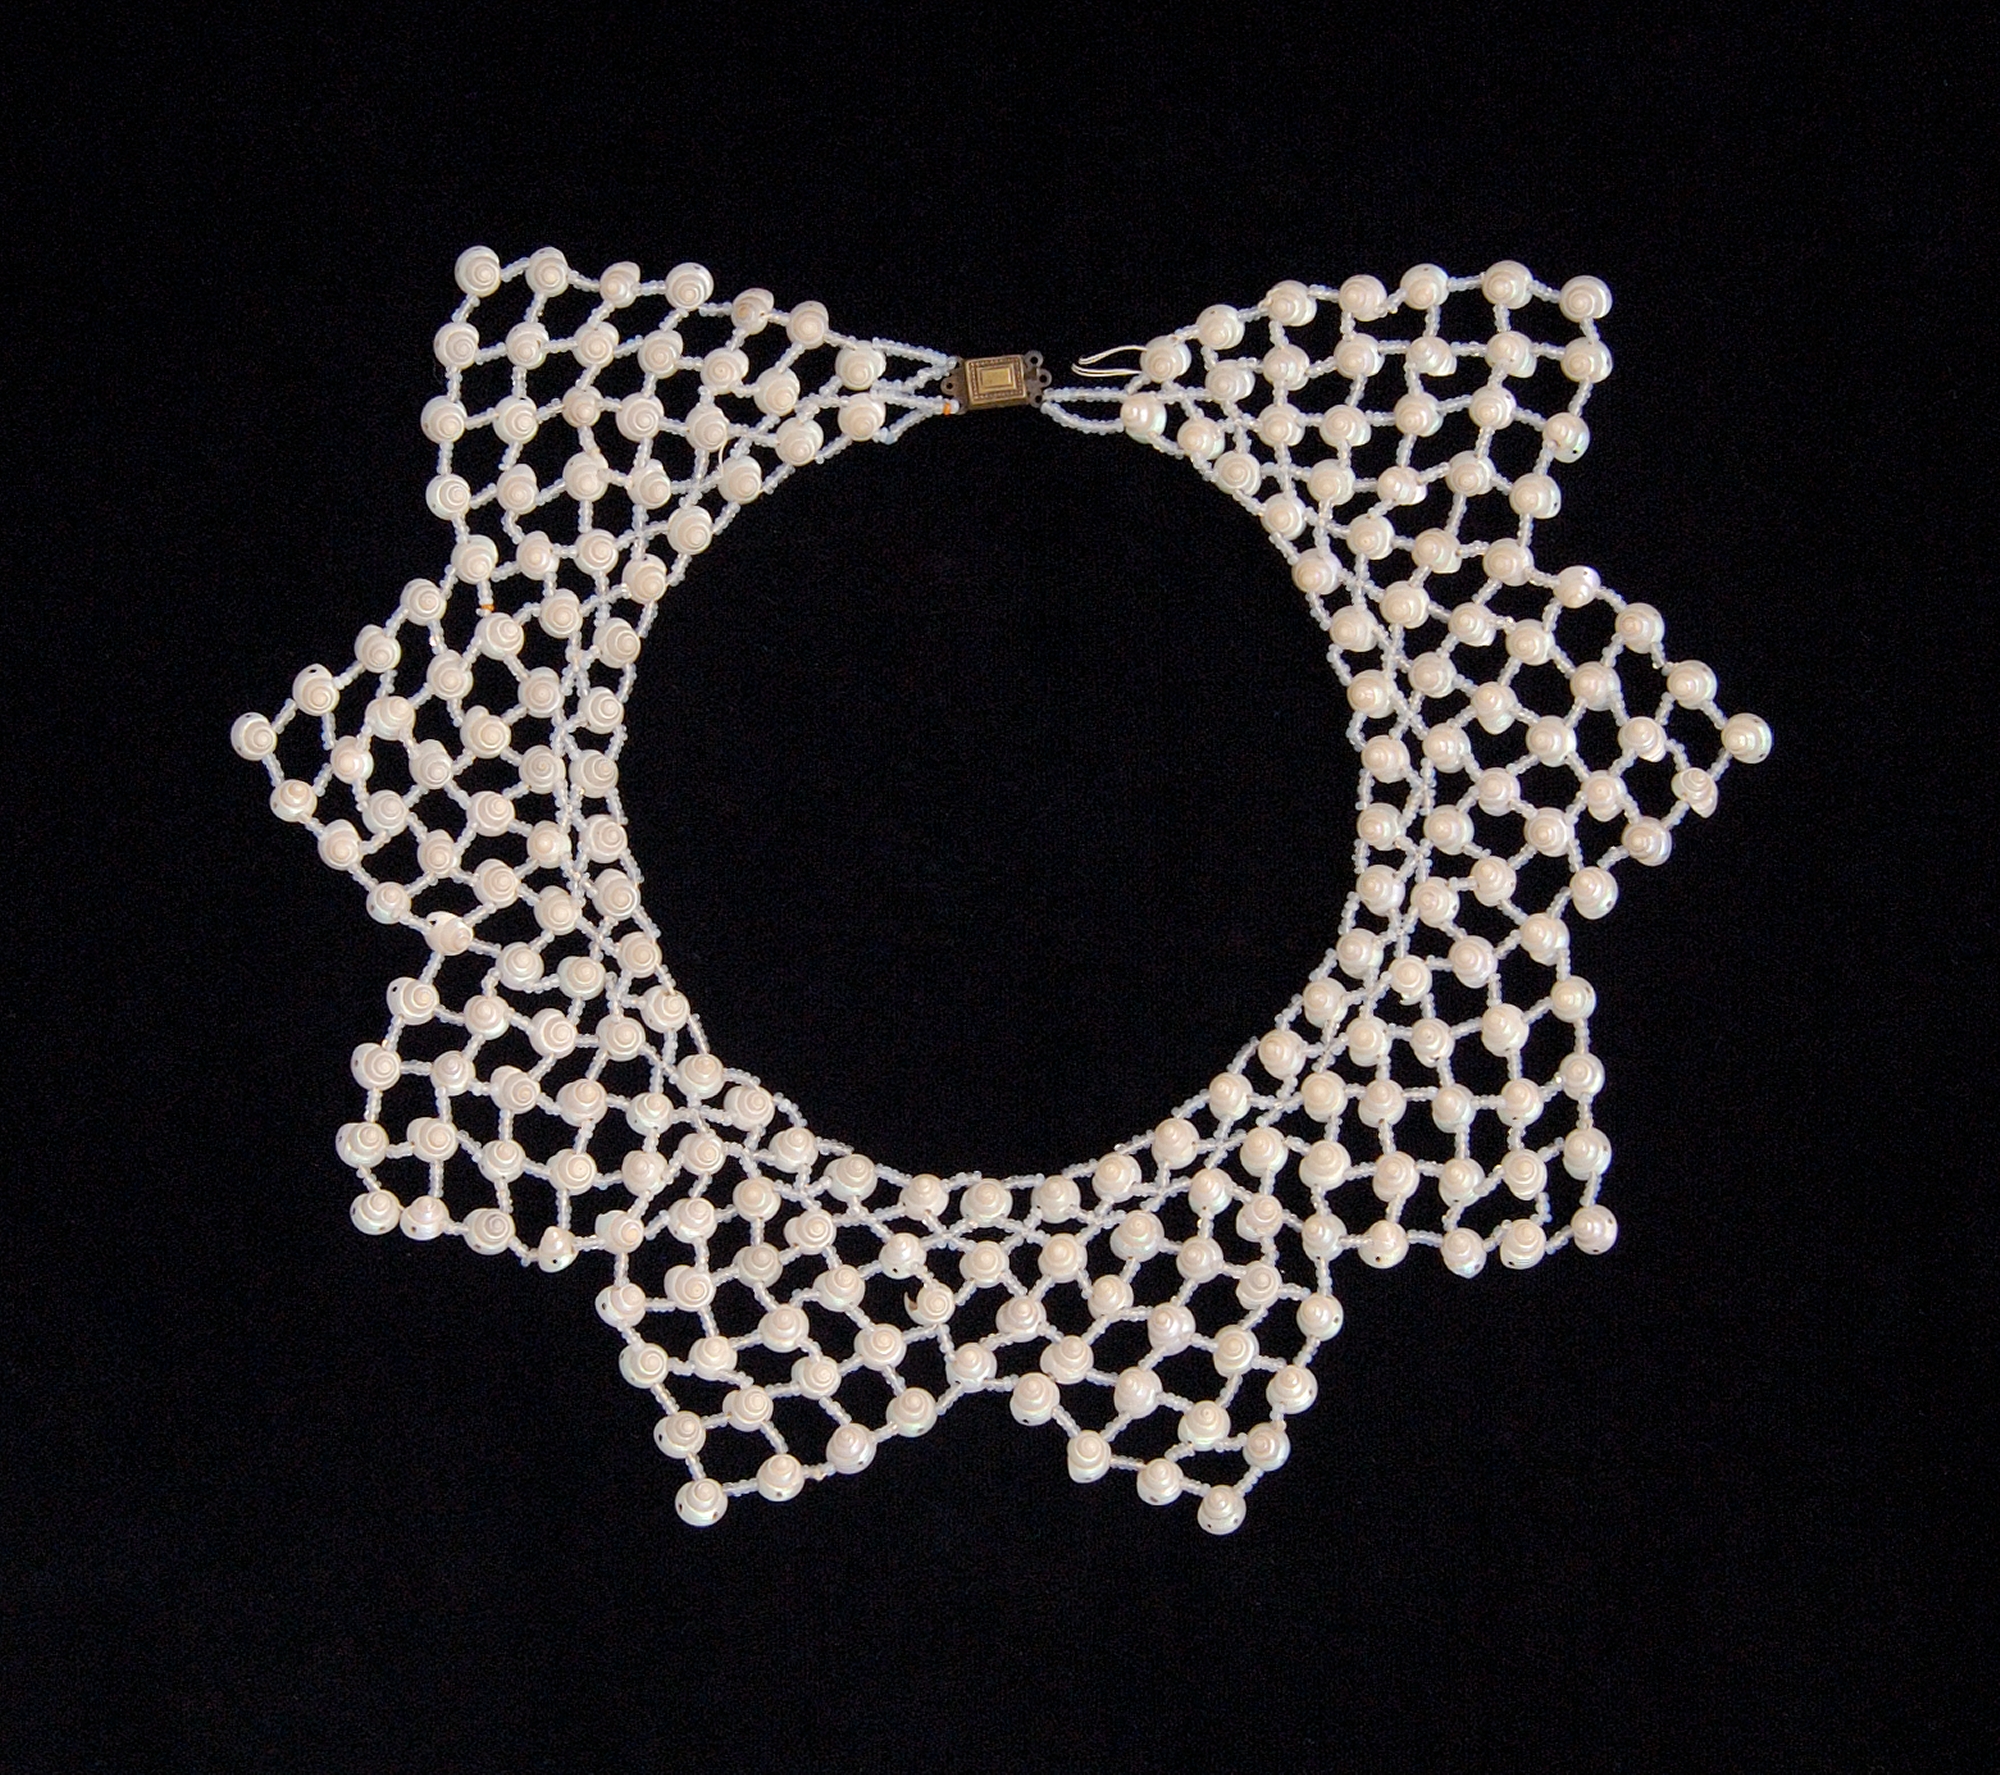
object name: necklace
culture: american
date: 1860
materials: glass, metal, shell